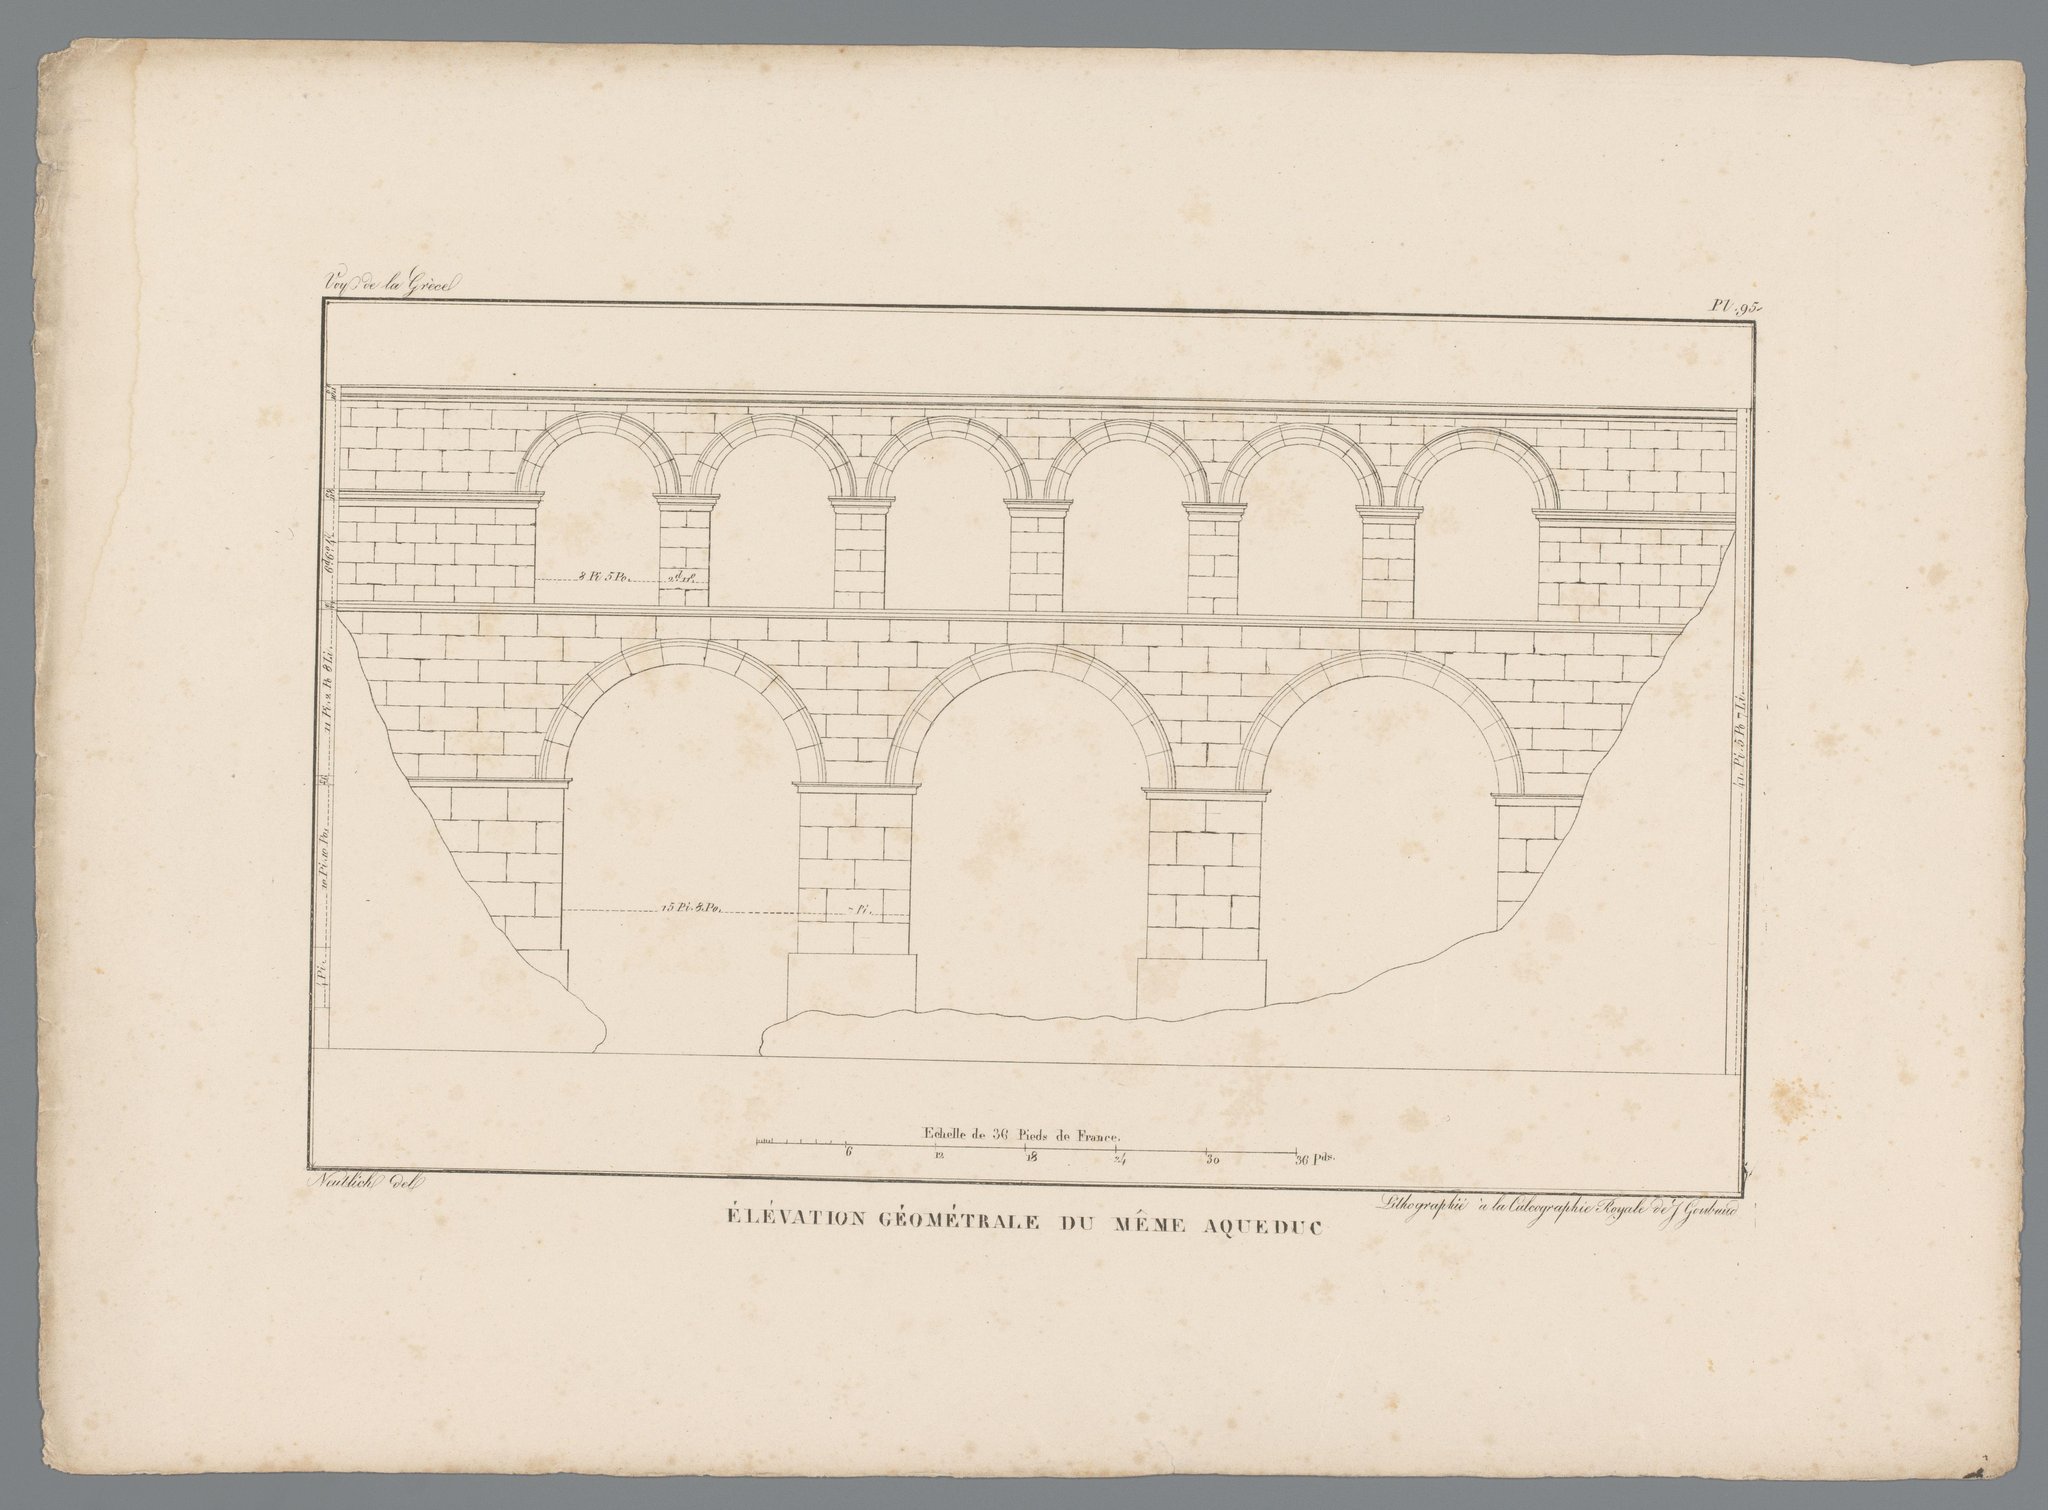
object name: print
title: Élévation géométrale du même aqueduc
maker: innocent louis goubaud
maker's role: draughtsman, painter, print maker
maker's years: 1770-1847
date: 1822-1825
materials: paper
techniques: lithograph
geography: brussels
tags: aqueduct (~ water supply)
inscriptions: collector's mark: Lugt 2228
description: Prent waarschijnlijk verschenen in: Choiseul-Gouffier, Marie-Gabriel-Auguste-Florent. Voyage pittoresque de la Grèce. Parijs: s.n., 1822-1825.